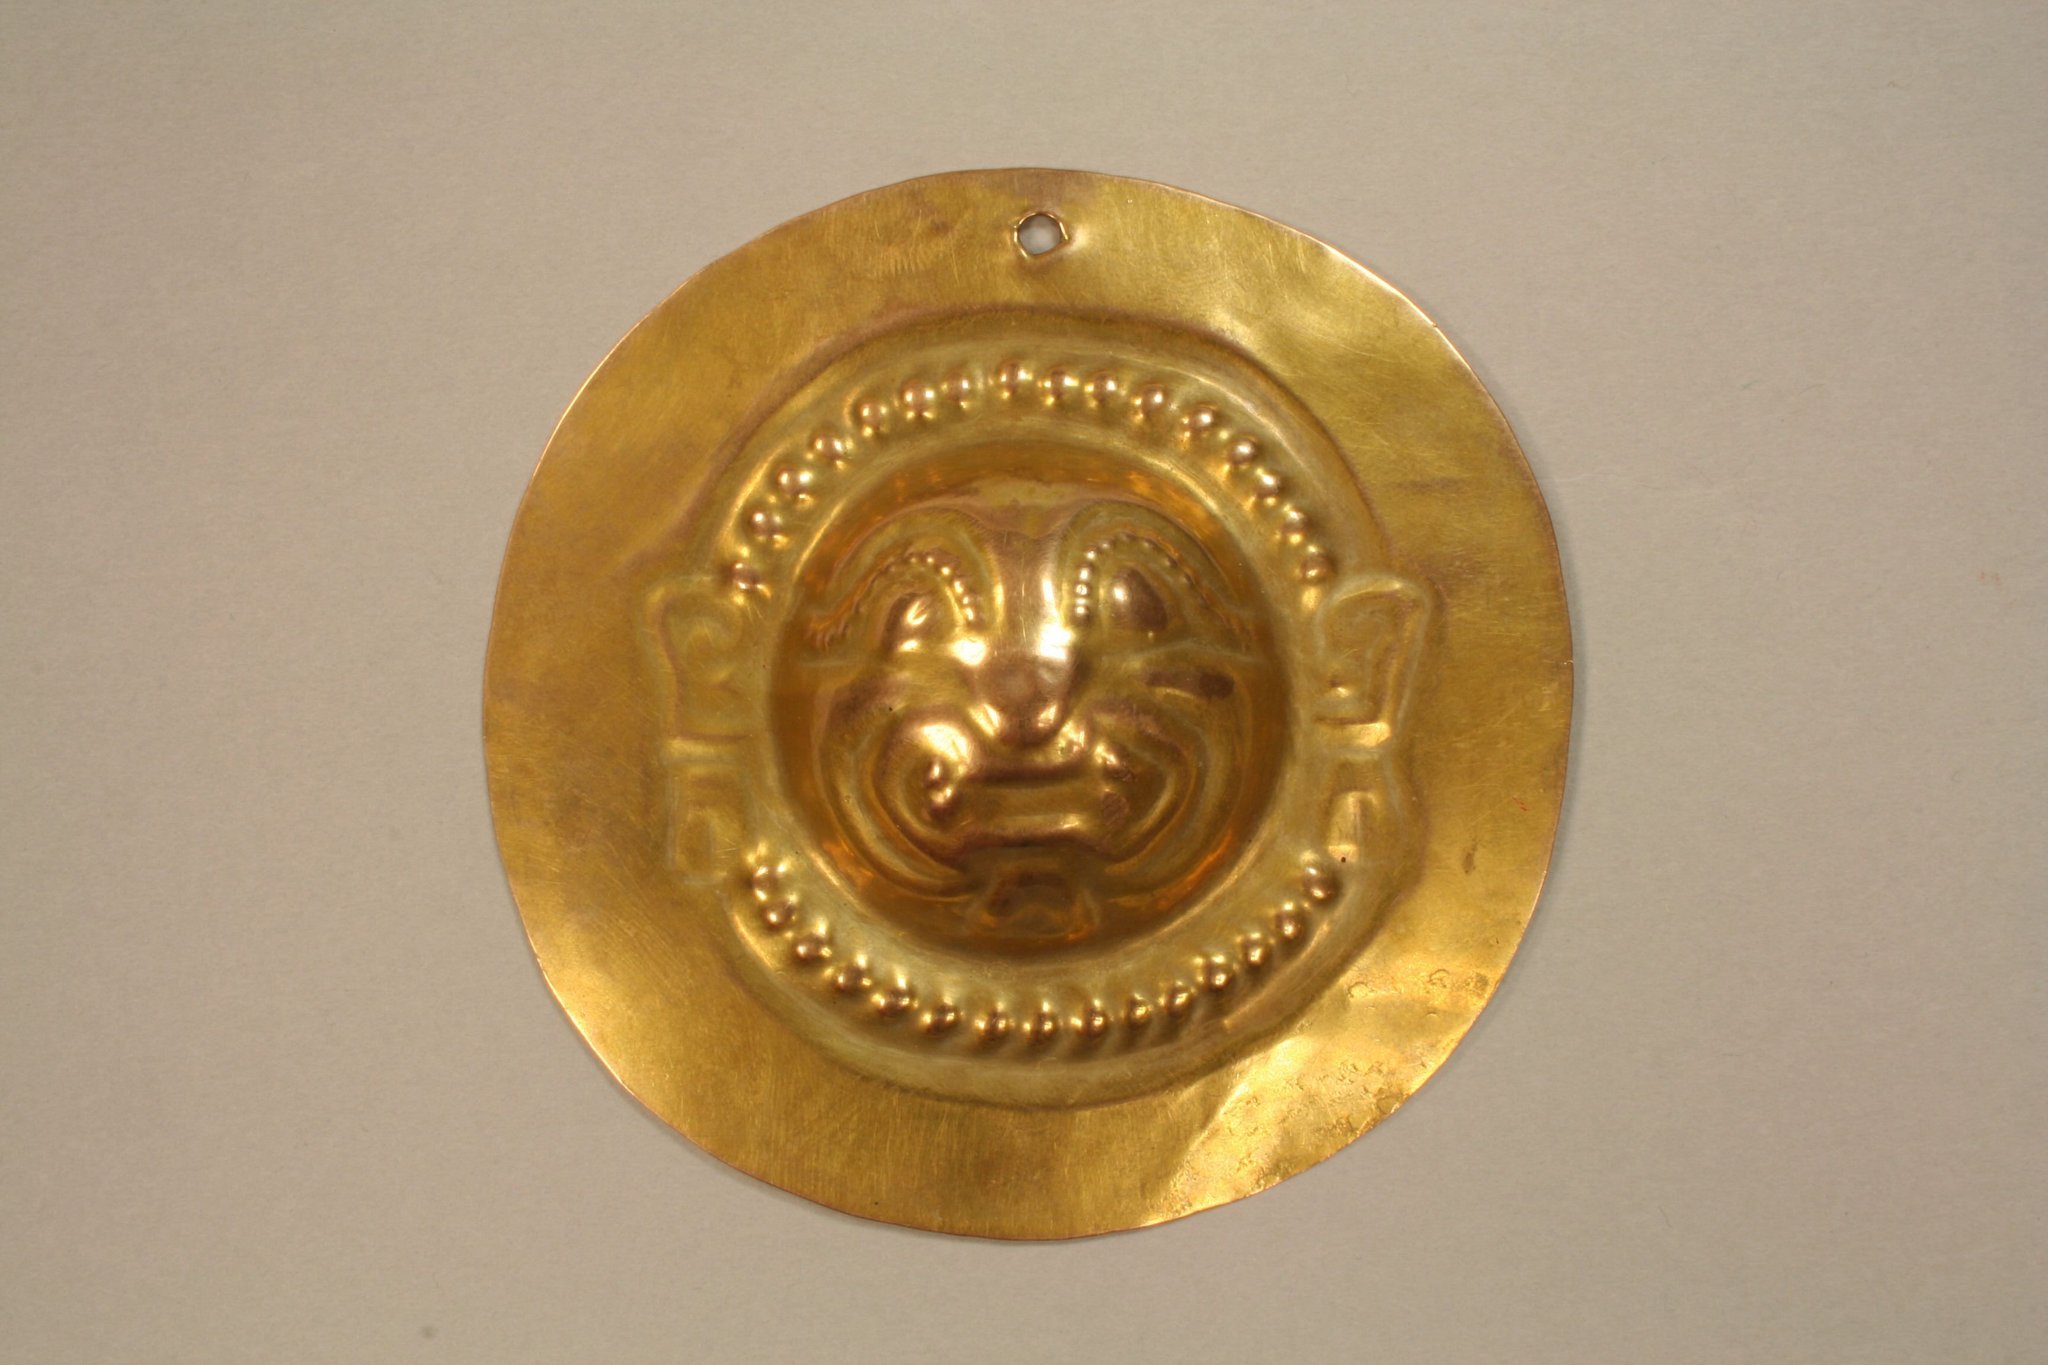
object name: disk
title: Mammalian disk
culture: carchi-nariño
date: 800-1500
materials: gold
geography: ecuador or colombia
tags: faces